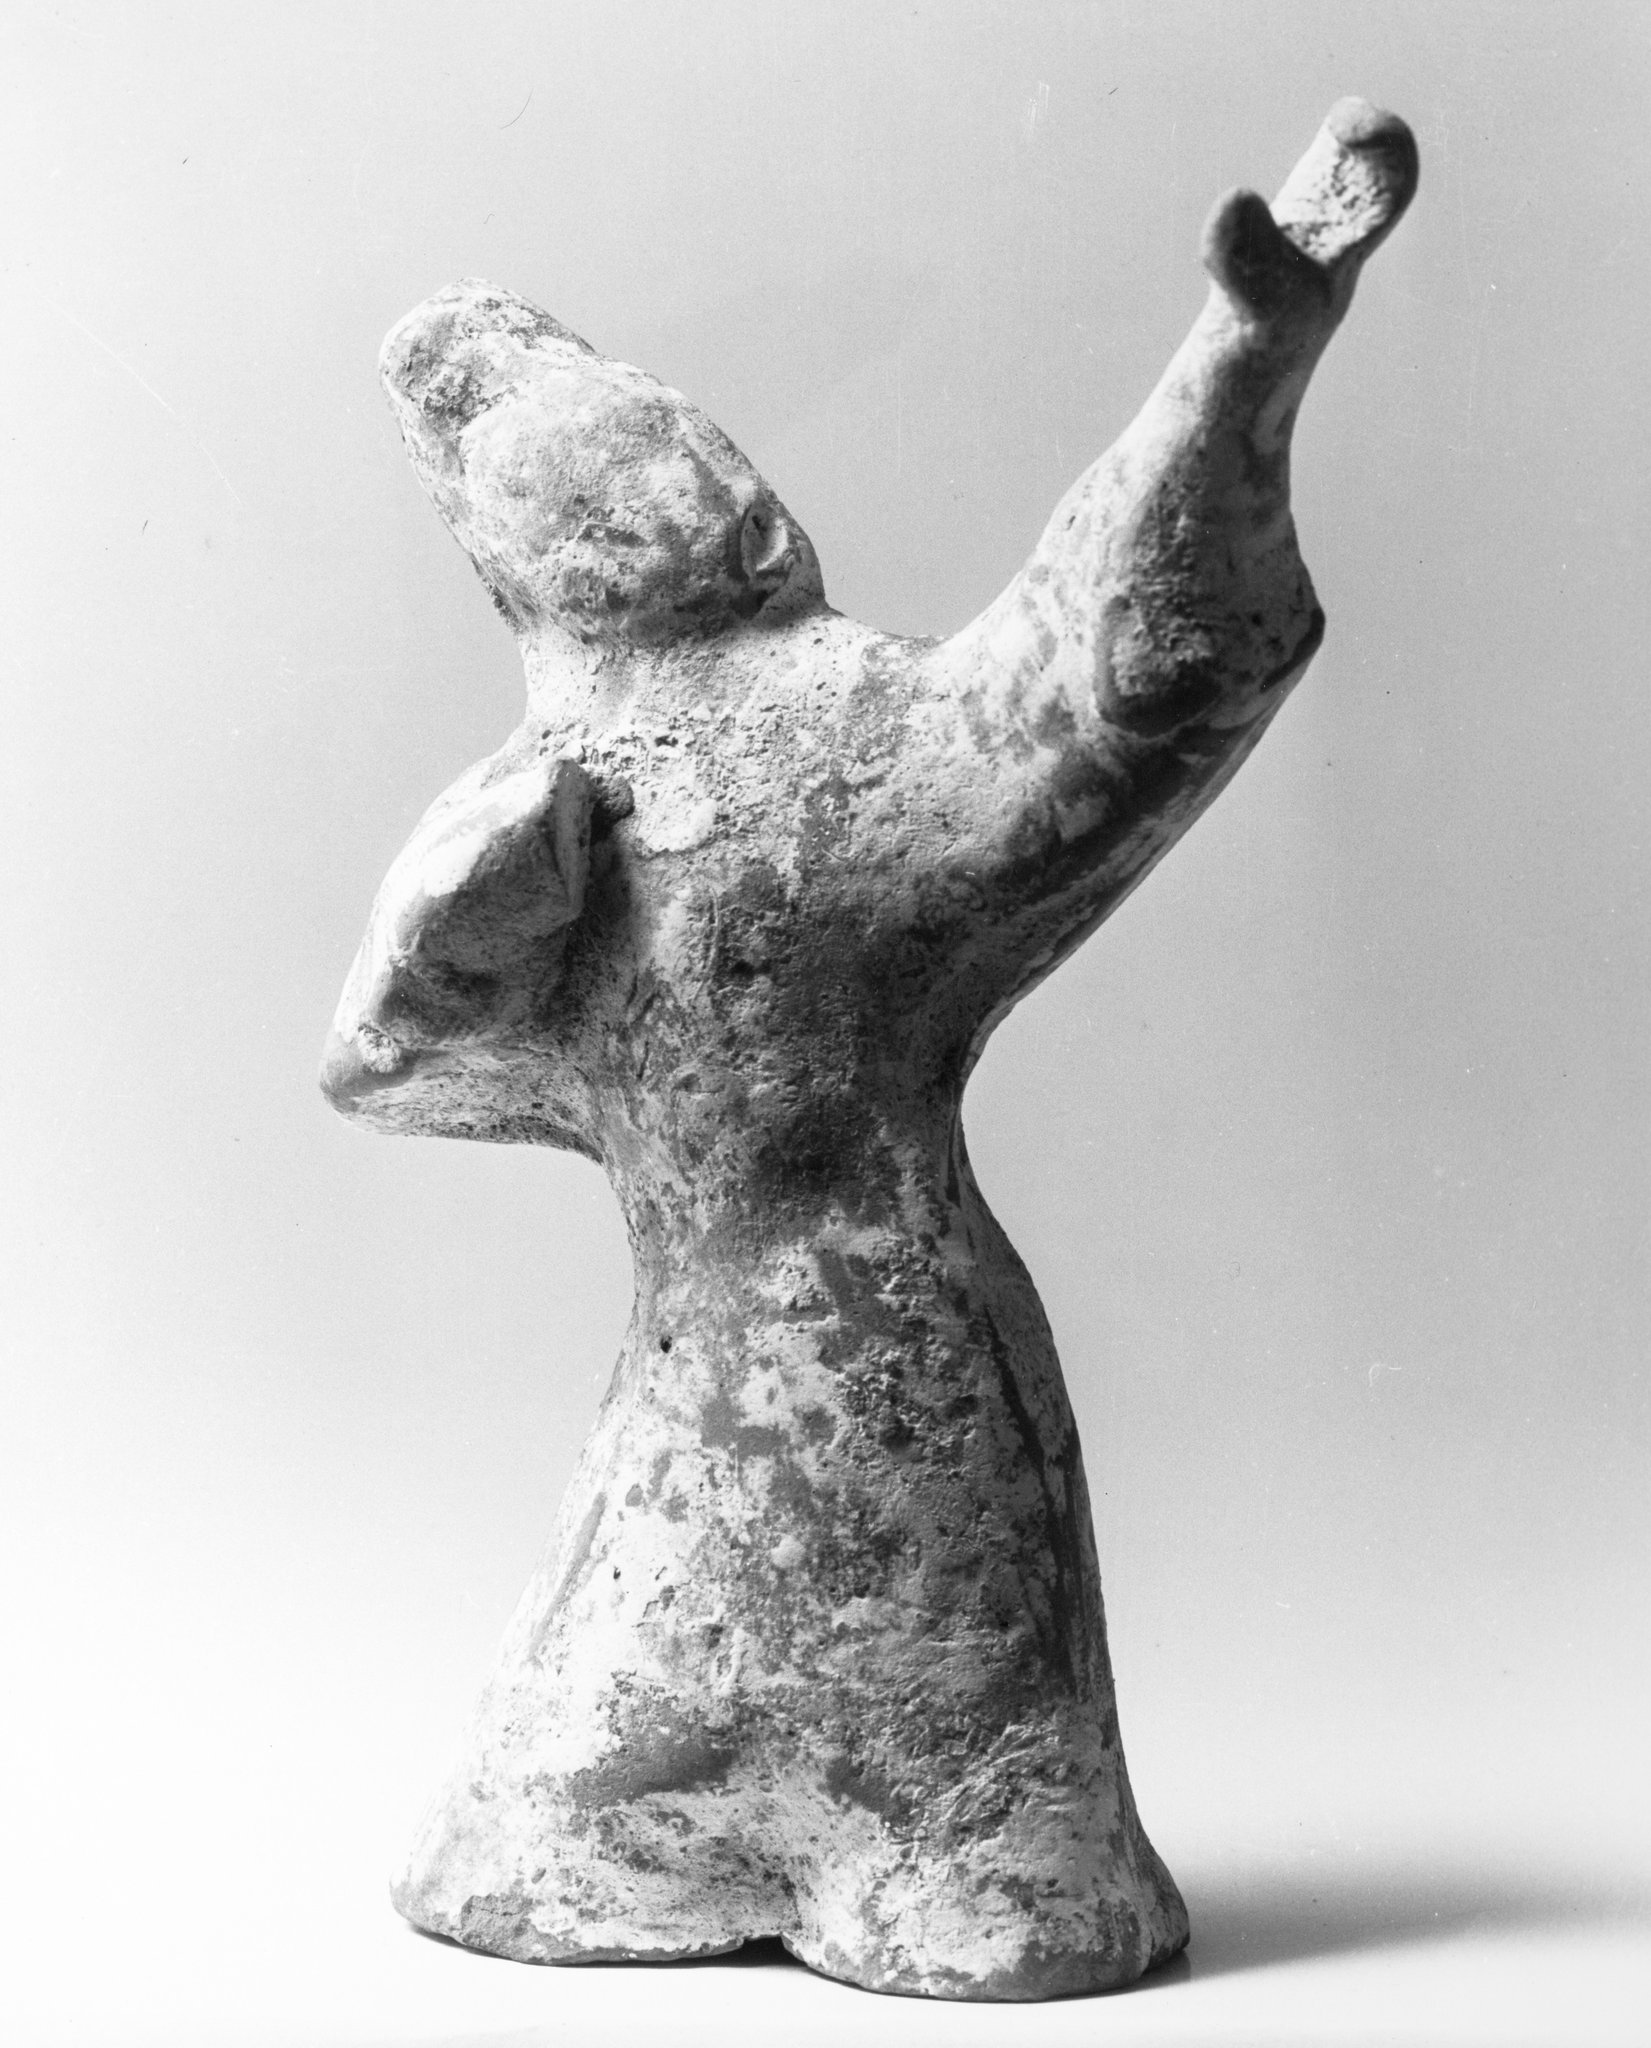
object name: figure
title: Figure of an Archer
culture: chinese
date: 206 BCE-220 CE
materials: pottery